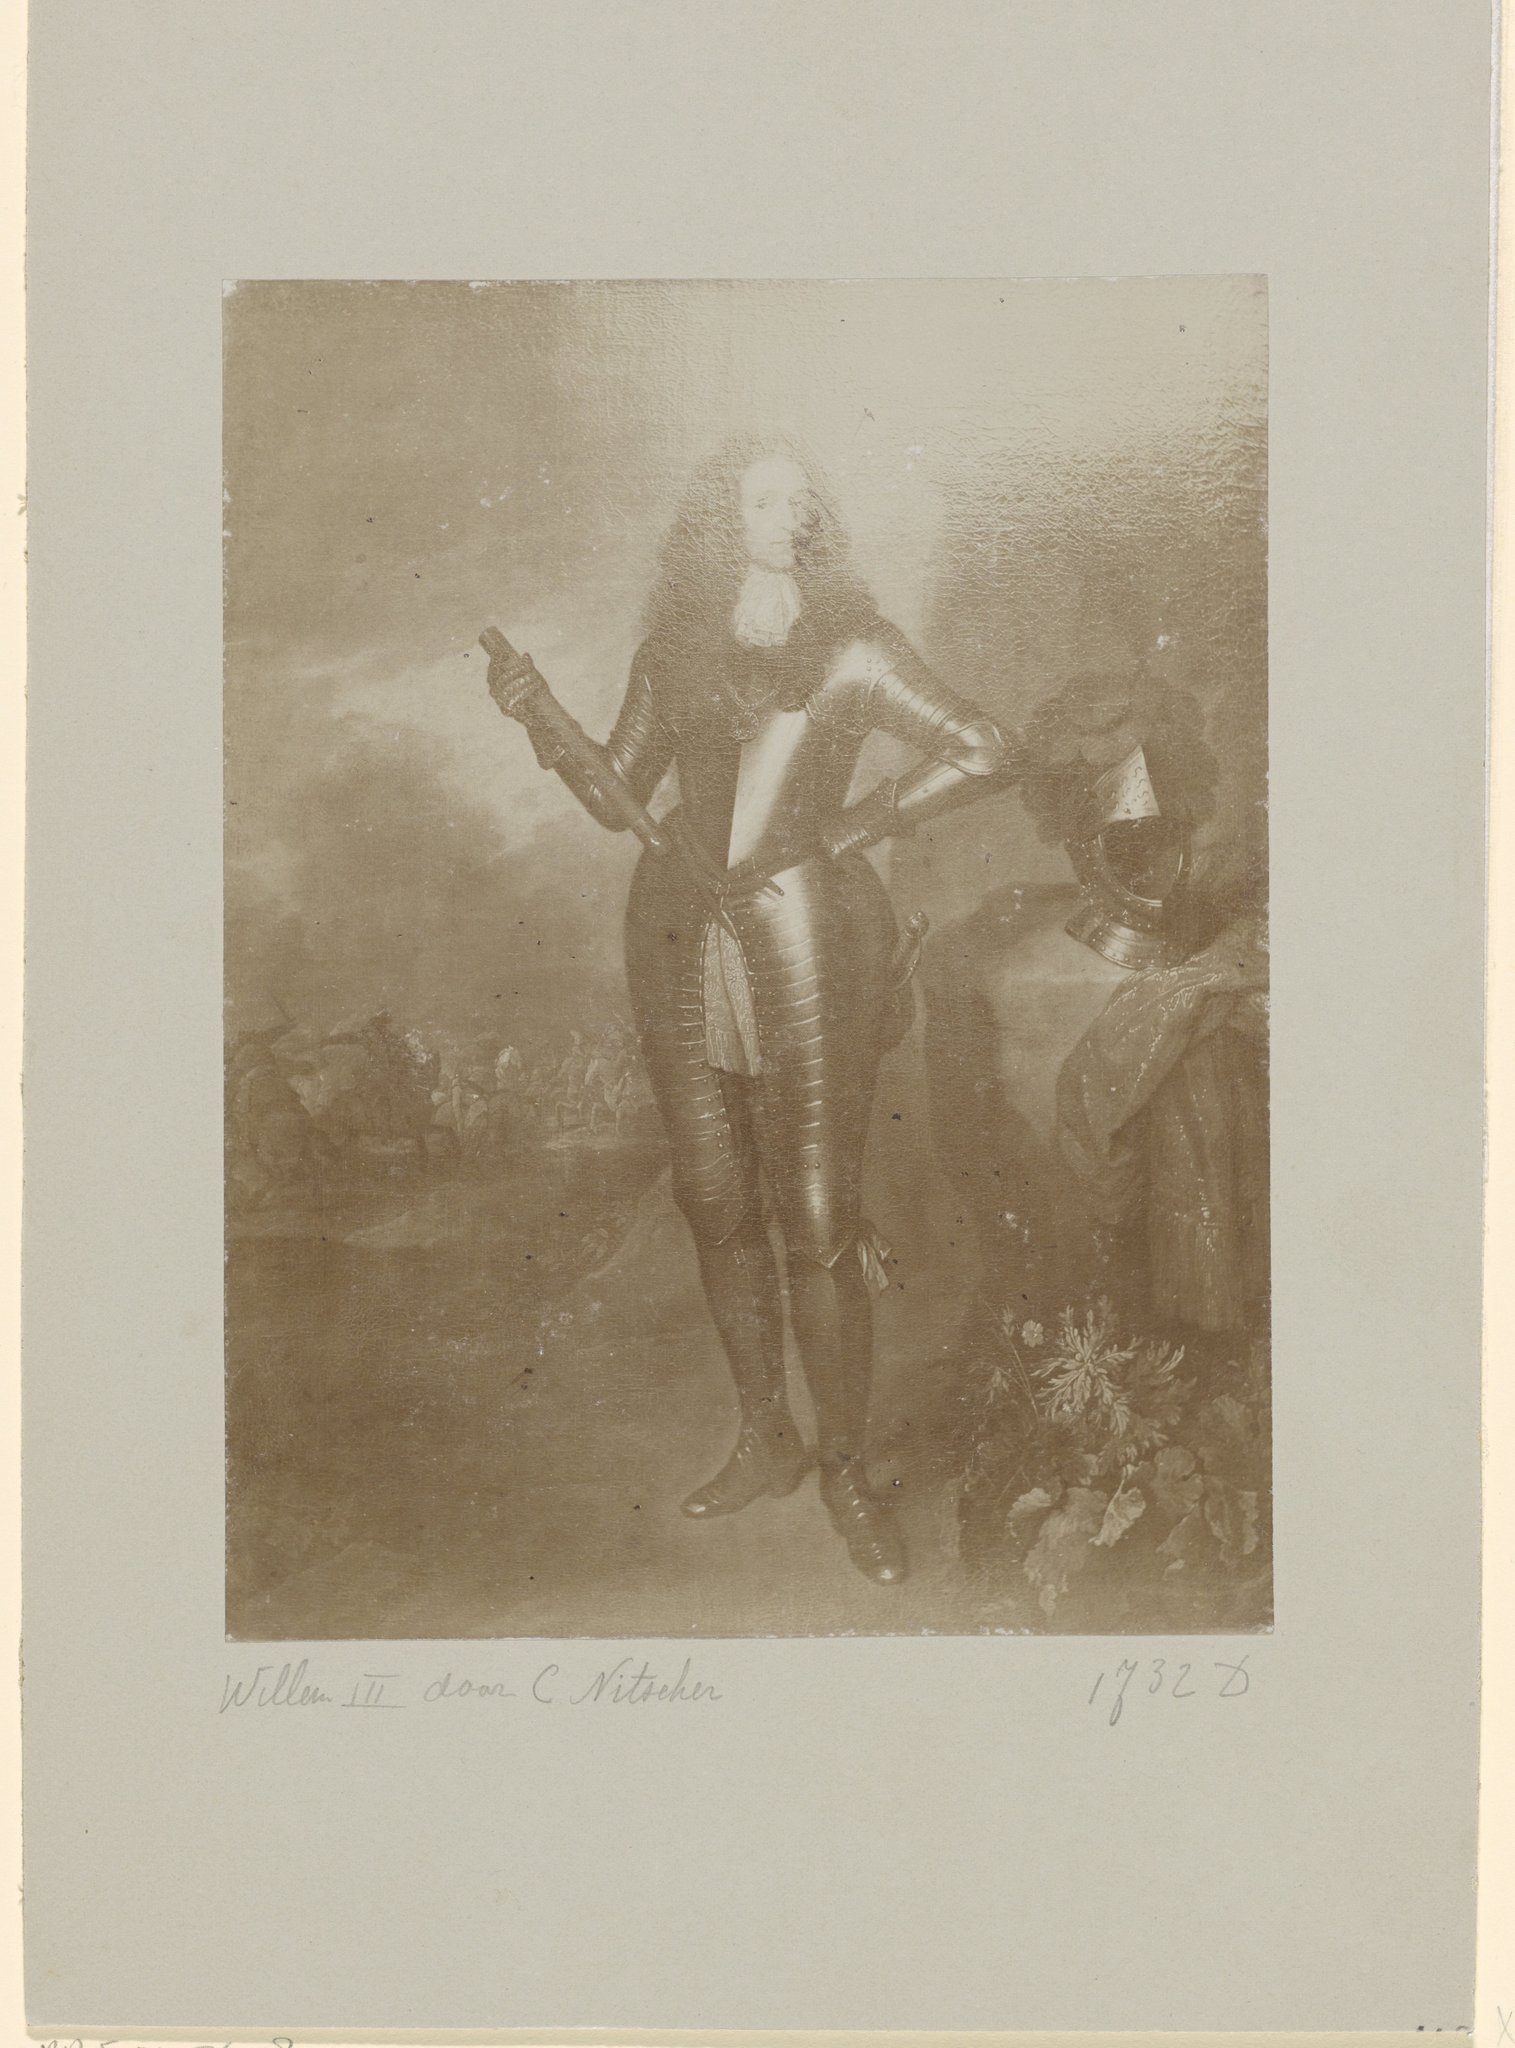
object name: photograph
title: Portret van Willem III, prins van Oranje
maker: Anonymous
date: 1850-1930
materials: photographic support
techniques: photography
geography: netherlands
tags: the hague, william iii (prince of orange and king of england, scotland, and ireland)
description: De hier vermelde titel verwijst naar de hoogst verkregen titel van de geportretteerde, niet per se naar de titel die de geportretteerde op deze voorstelling draagt.